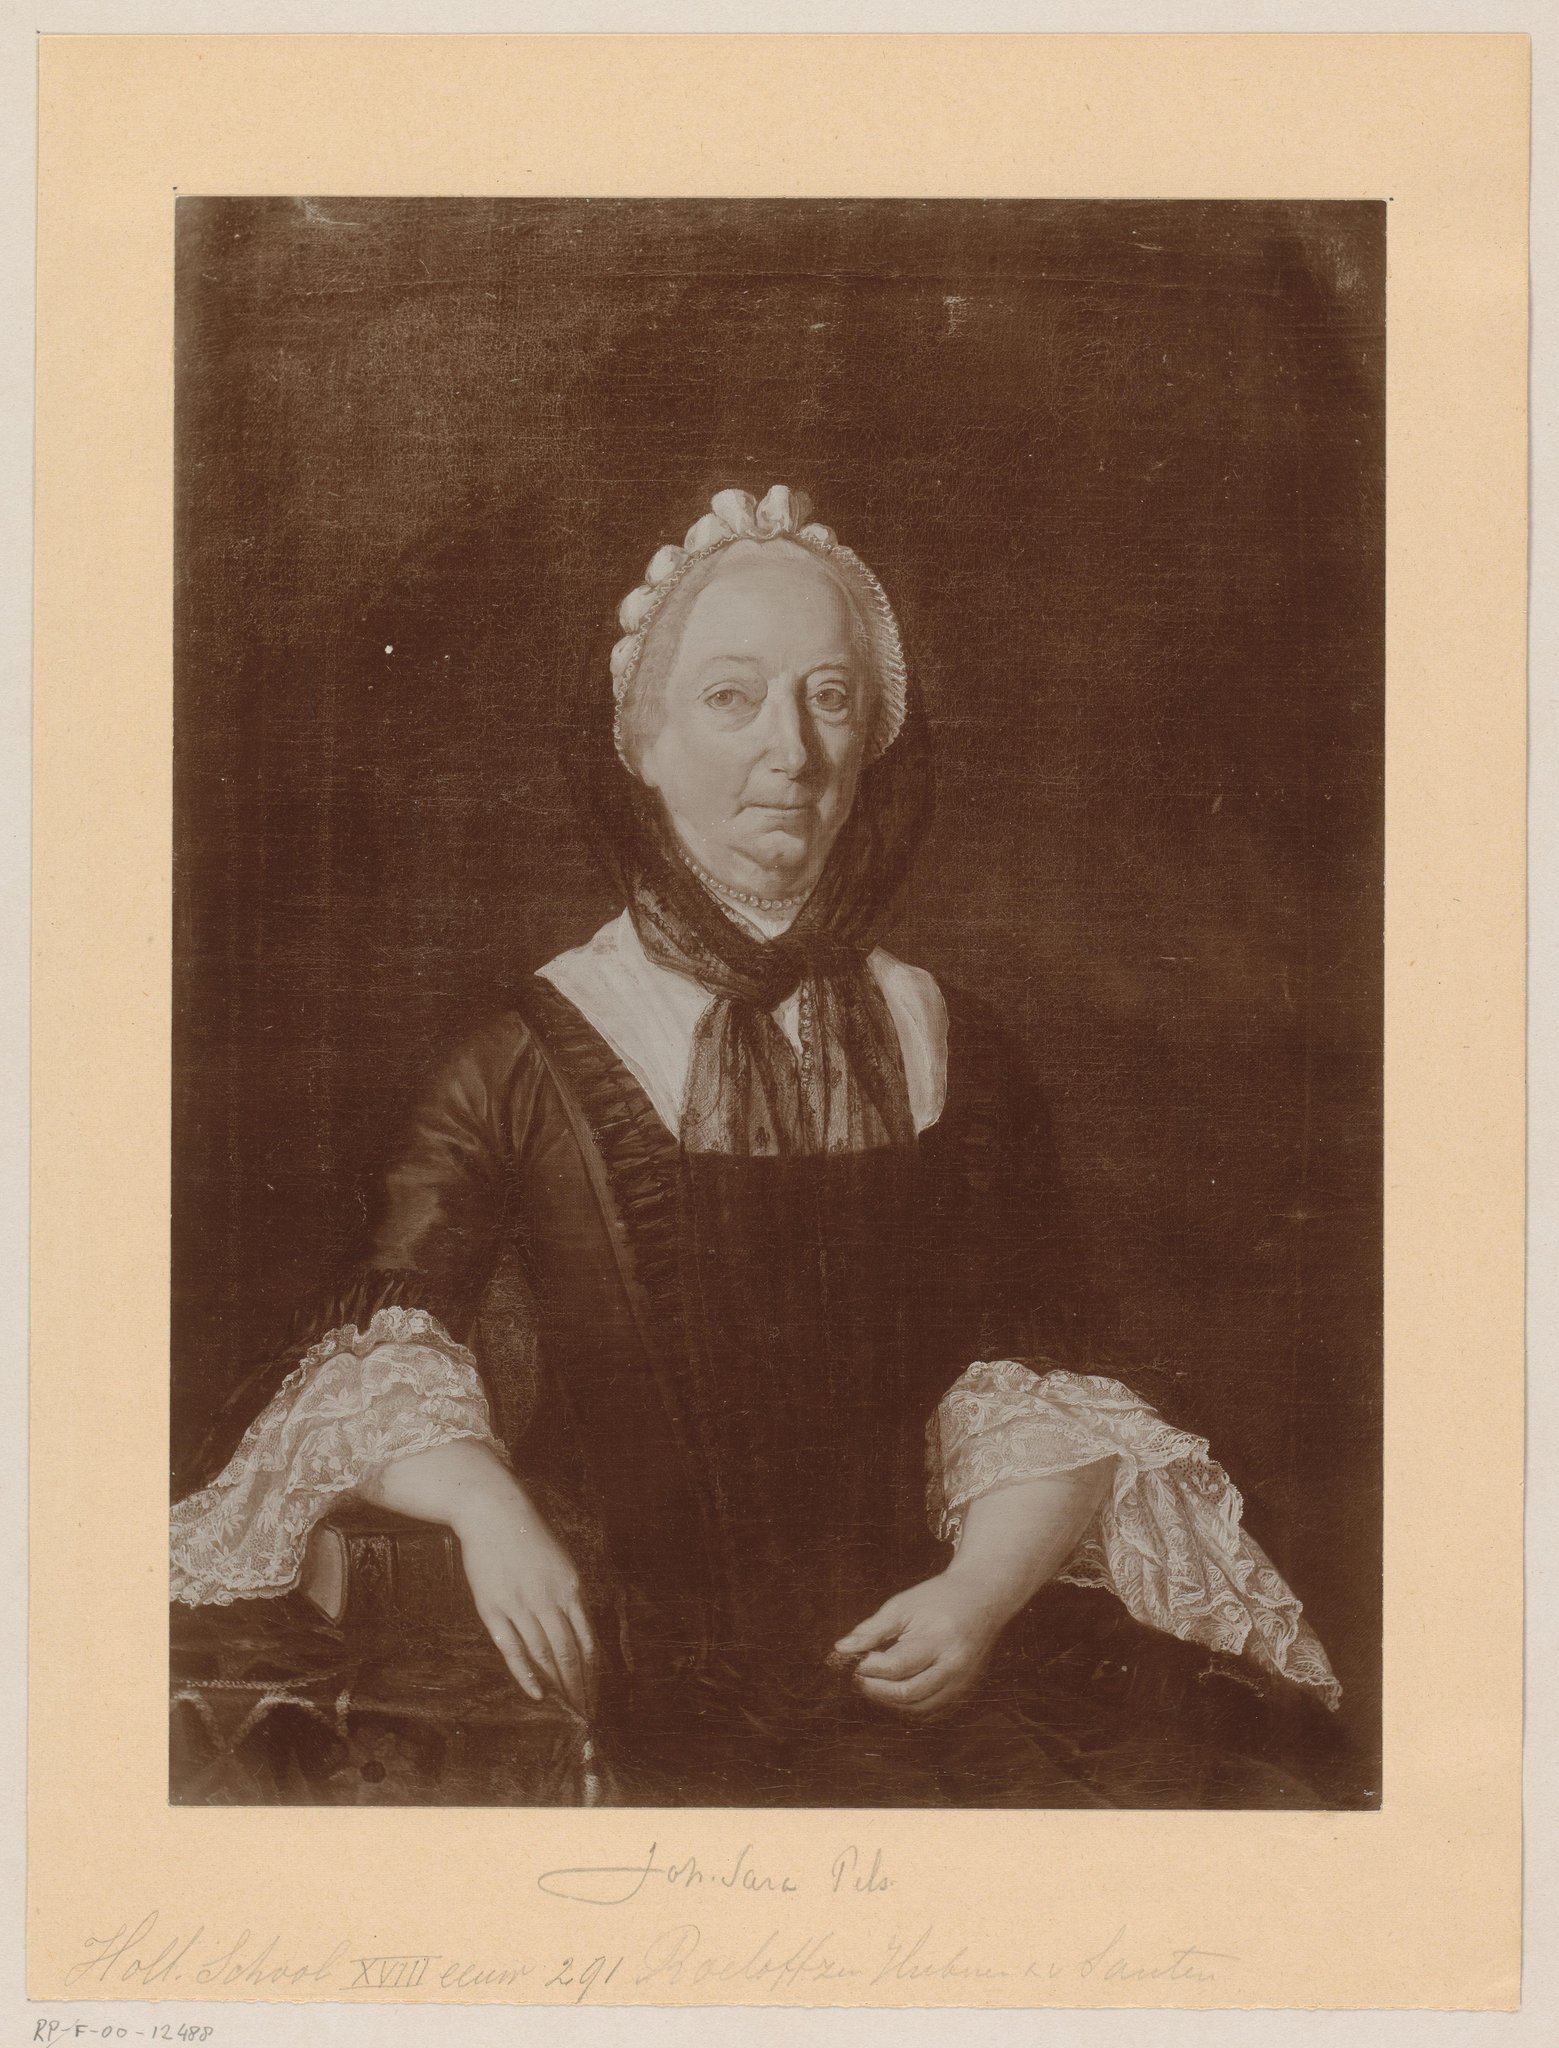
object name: photograph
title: Fotoreproductie van een geschilderd portret van Johanna Sara Pels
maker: Anonymous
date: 1890-1930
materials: paper, cardboard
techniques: gelatin silver print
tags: historical persons - bb - woman